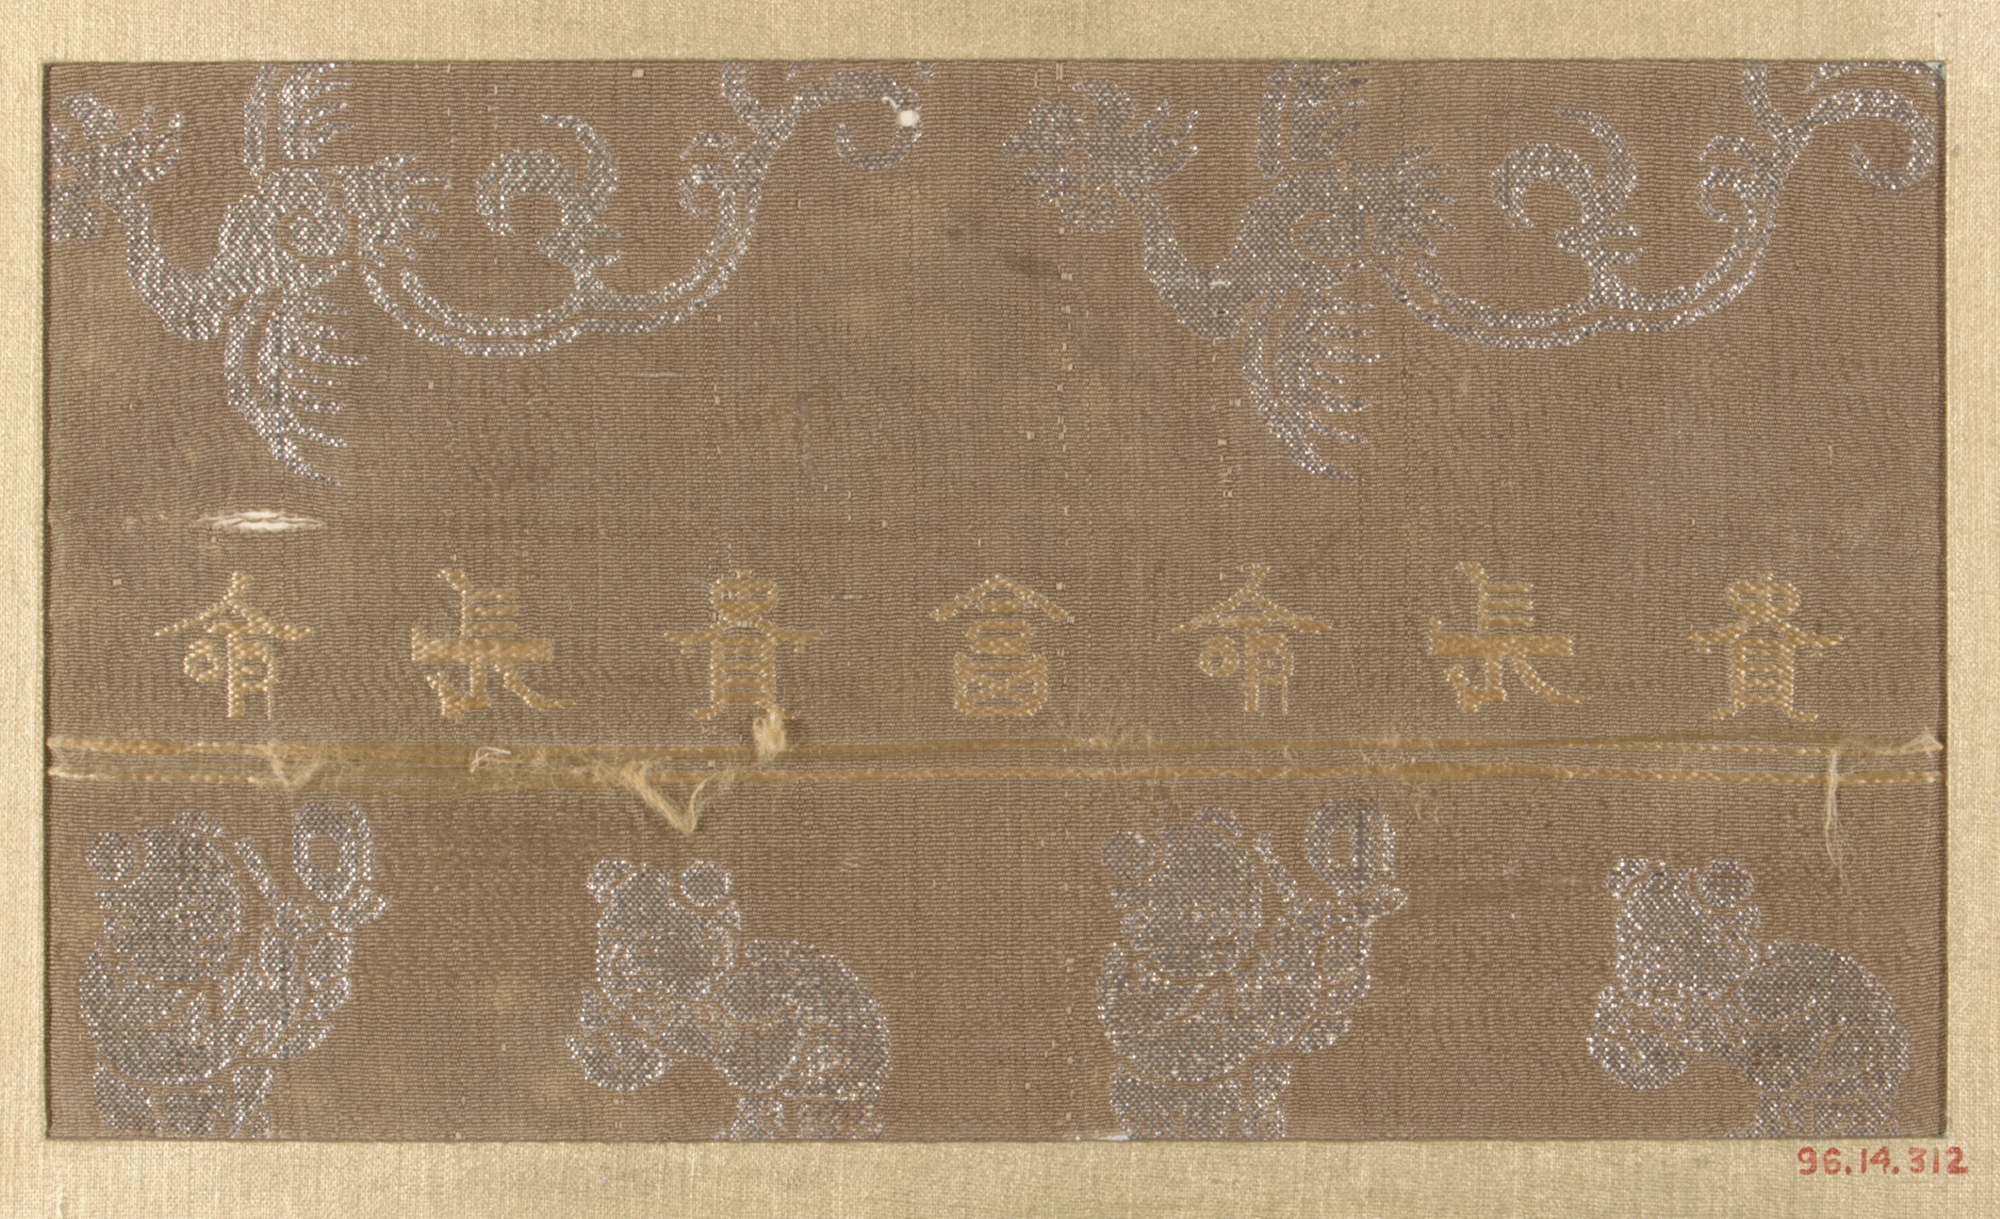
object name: piece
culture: japanese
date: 1701-1900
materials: silk